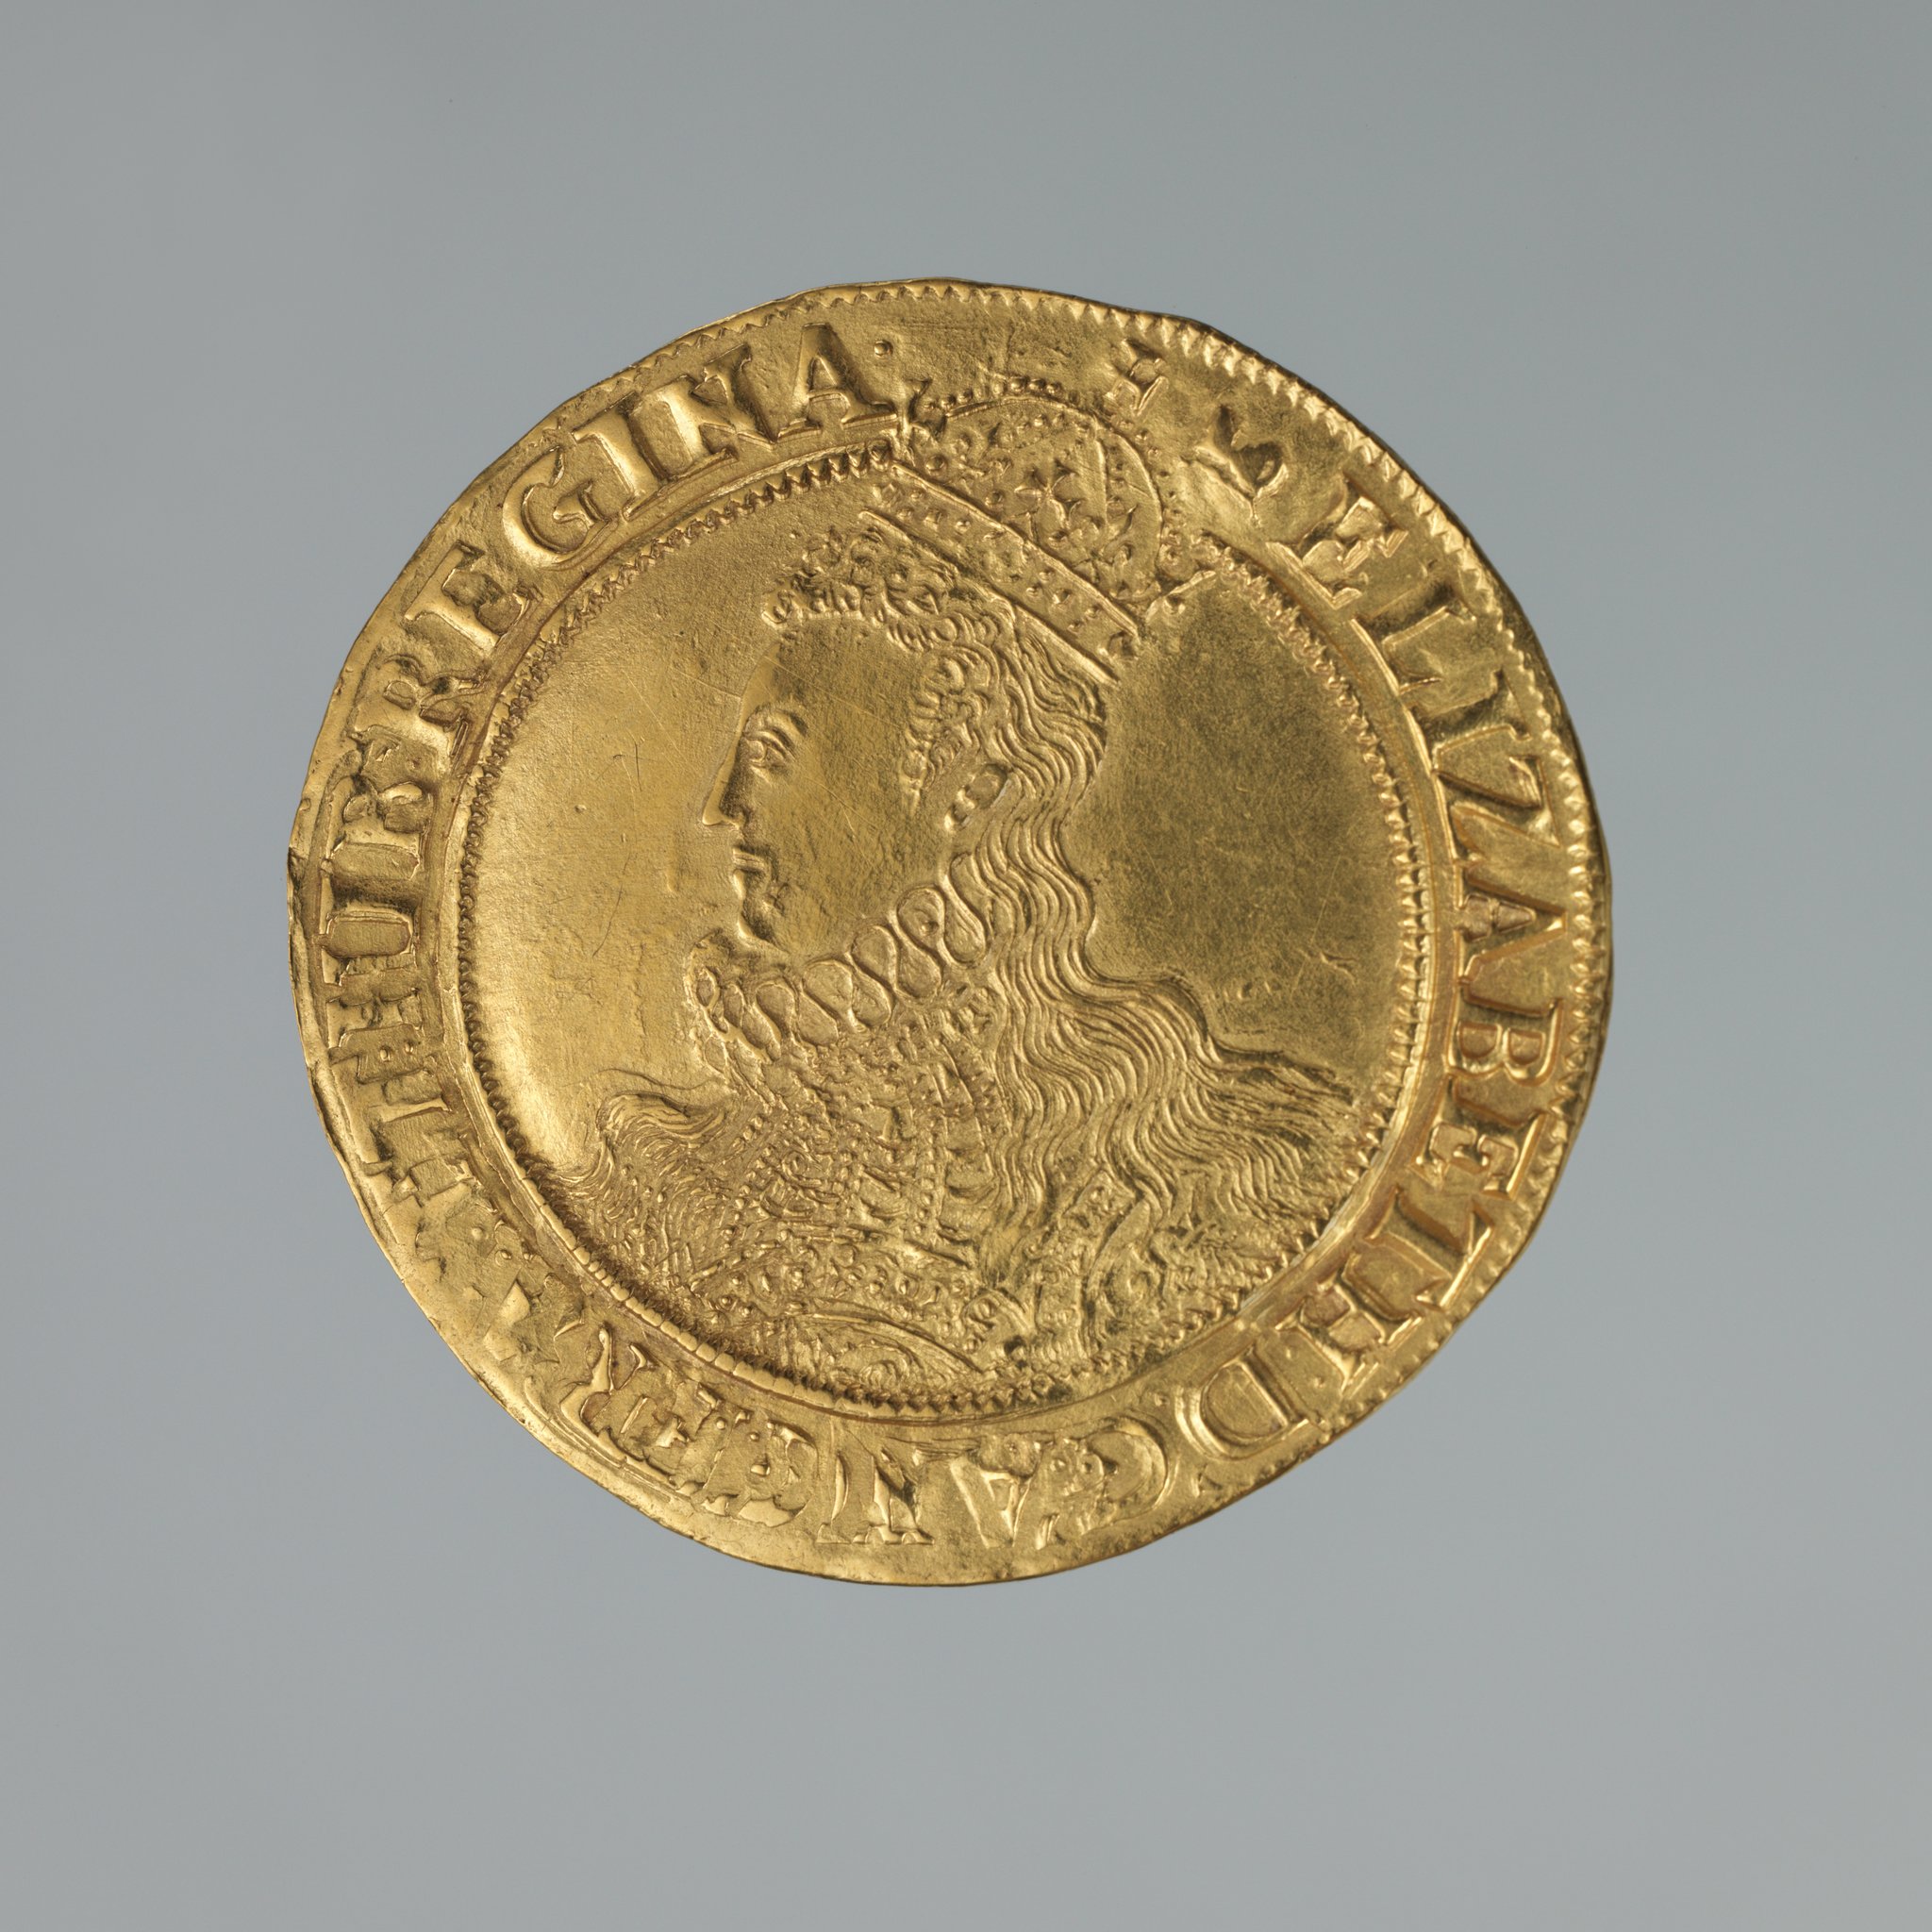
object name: sovereign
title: Crown gold sovereign of Elizabeth I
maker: the royal mint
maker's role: maker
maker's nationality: british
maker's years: 886-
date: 1593-1601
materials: gold